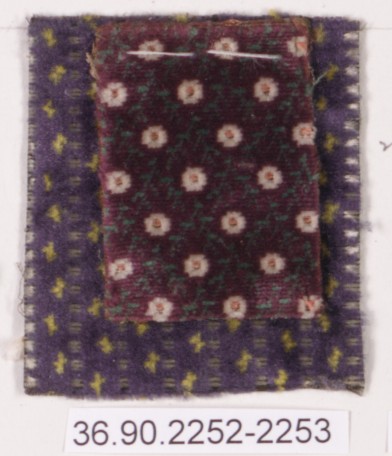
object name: piece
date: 1801-1900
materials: silk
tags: flowers